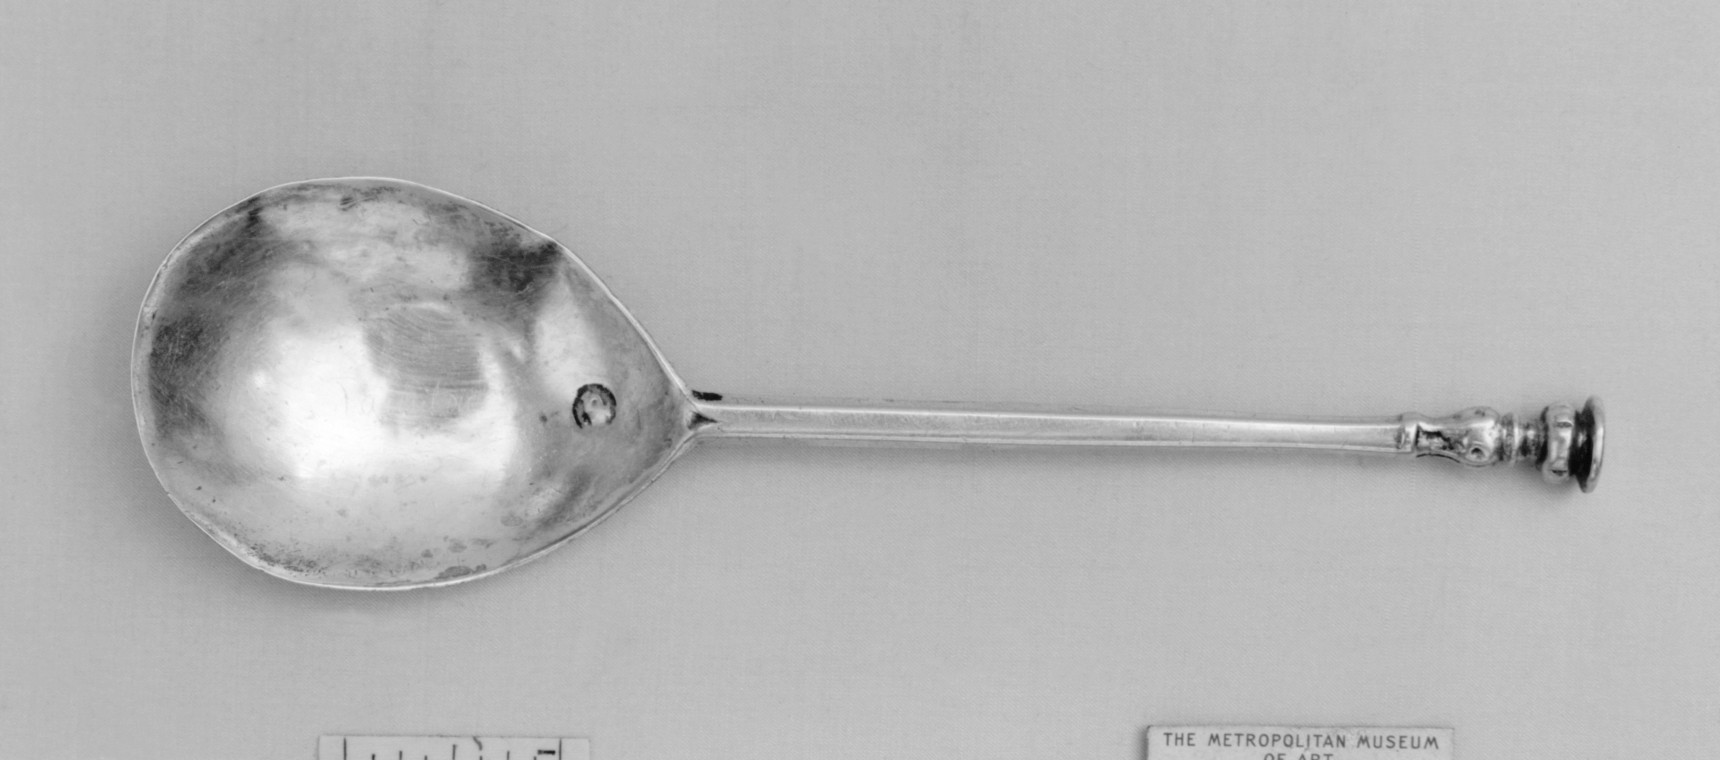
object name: spoon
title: Seal-top spoon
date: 1640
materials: gilt, silver